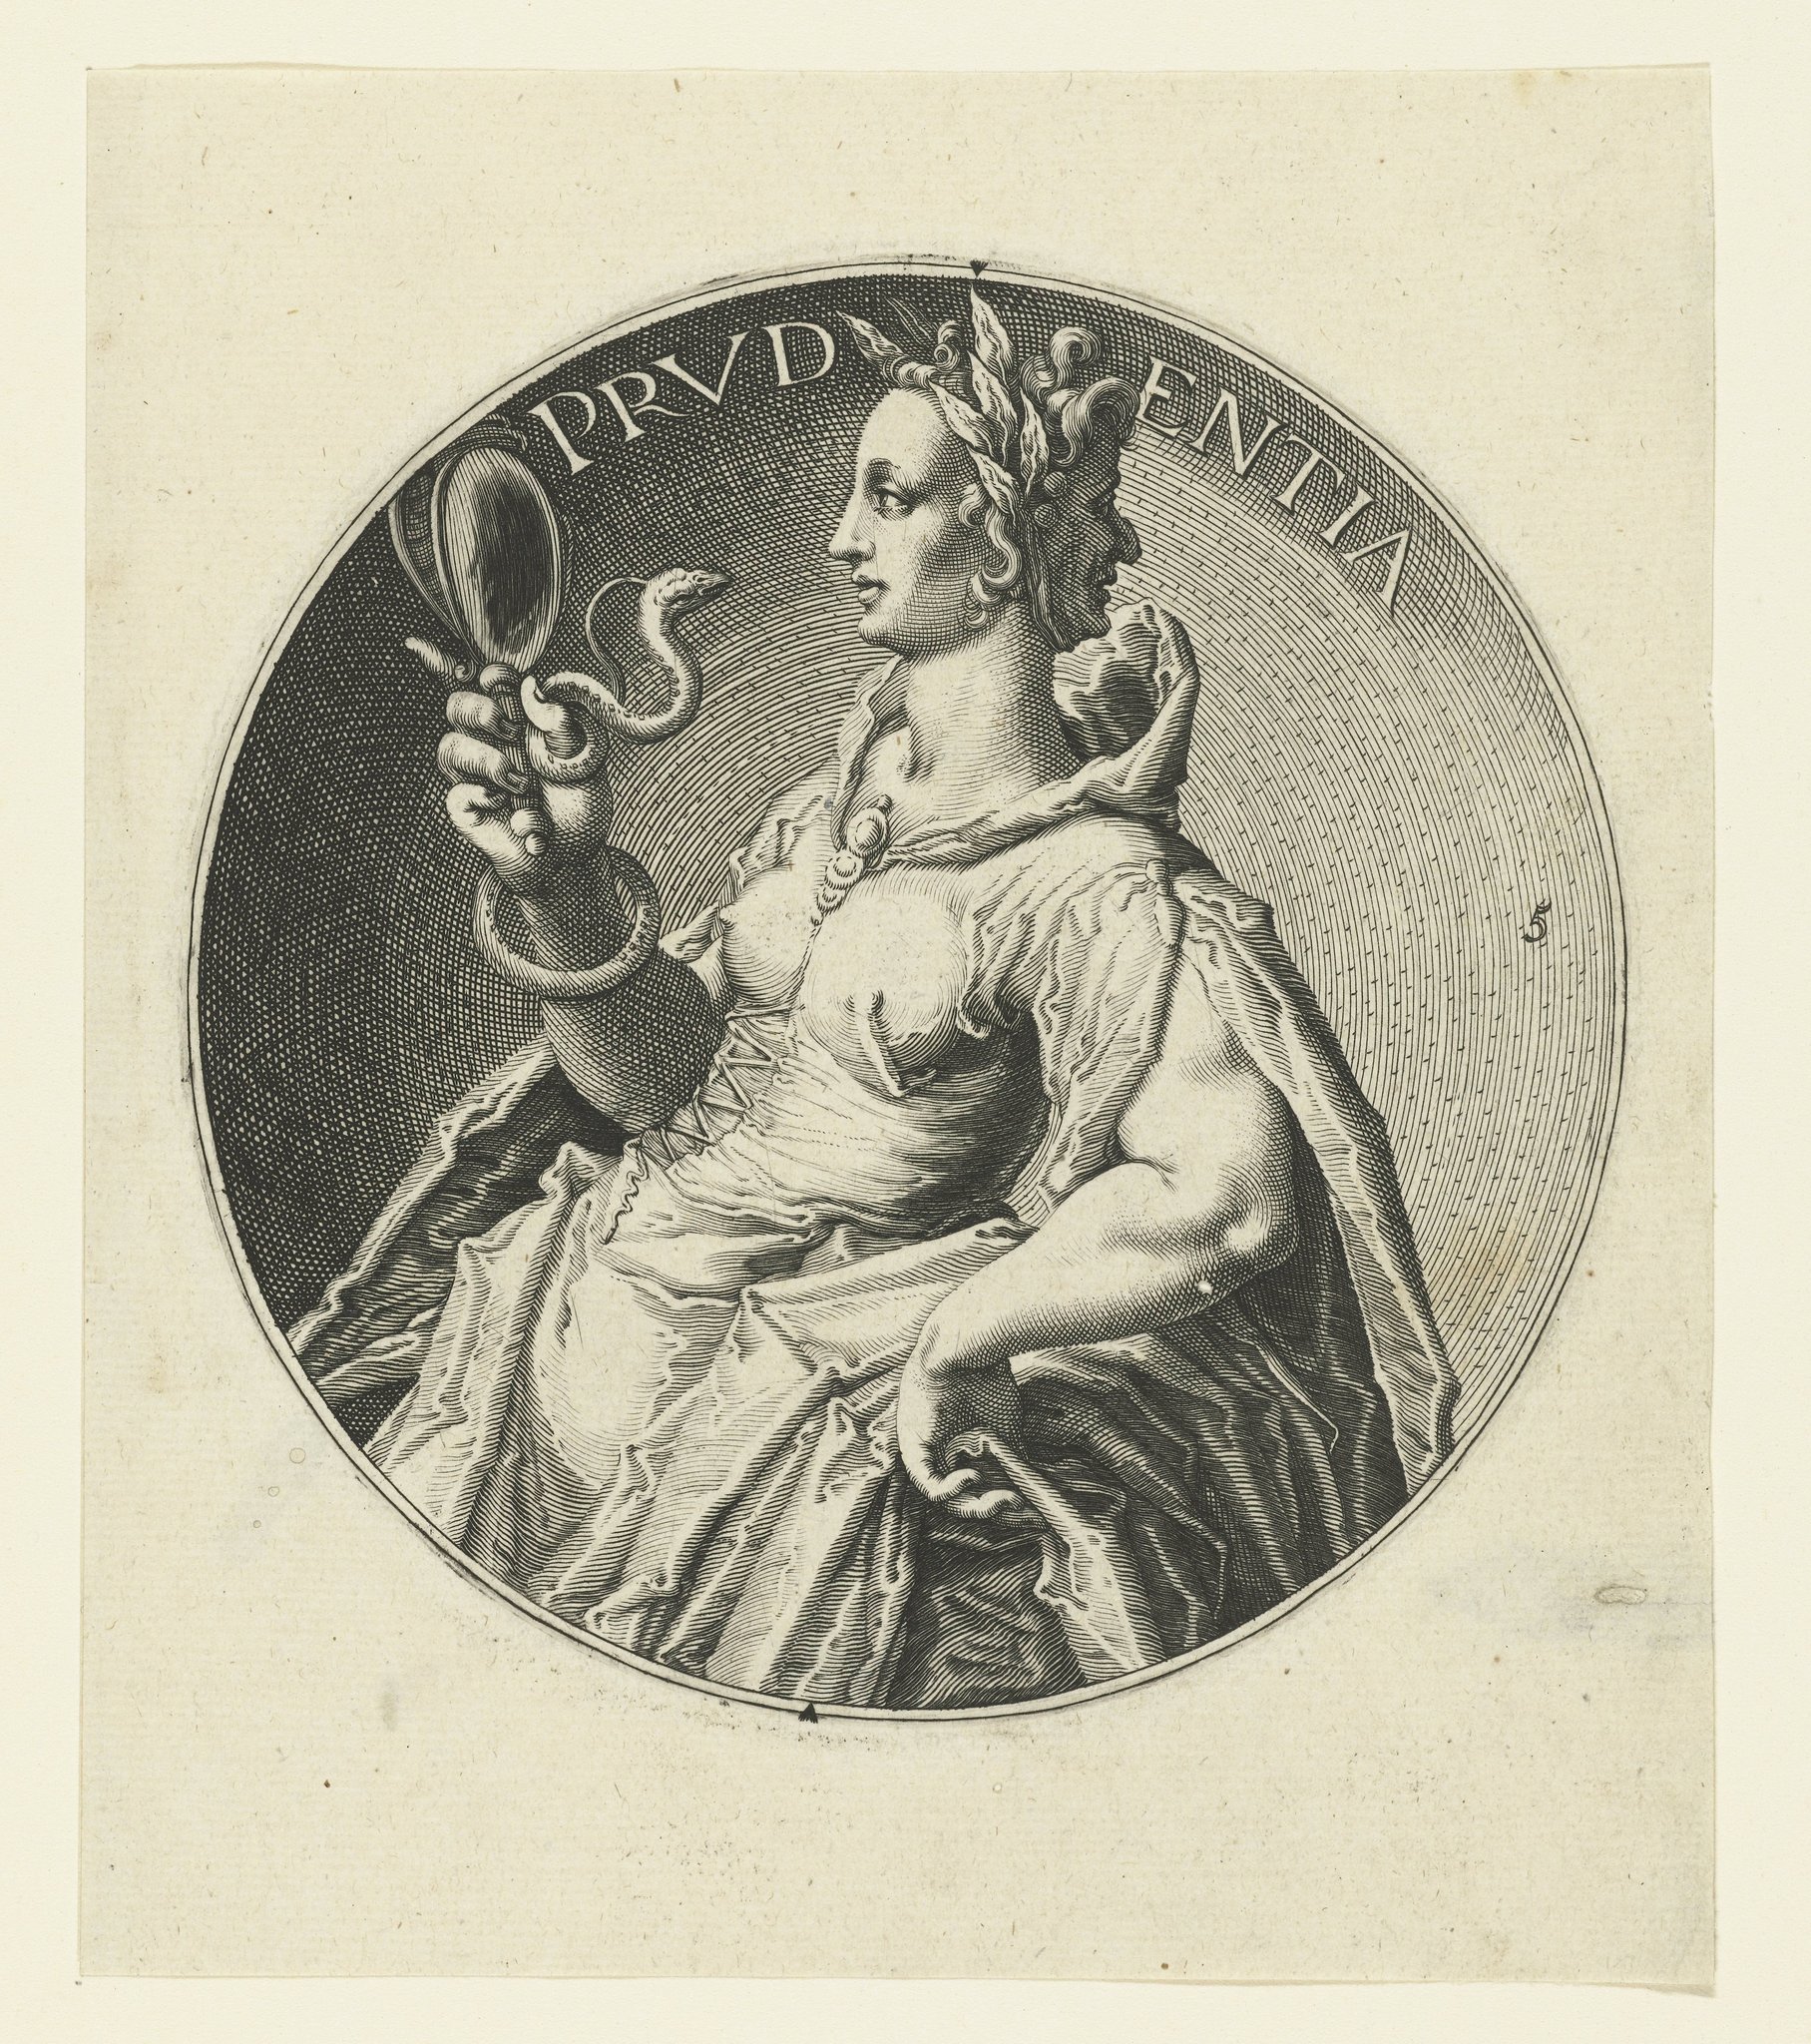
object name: print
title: Prudentia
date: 1591-1595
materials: paper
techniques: engraving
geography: netherlands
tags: prudence, 'prudentia'; 'prudenza' (ripa) ~ one of the four cardinal virtues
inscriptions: collector's mark: Lugt 2228a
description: Voorzichtigheid, in de gedaante van een vrouw met een spiegel in de rechterhand, waaromheen een slang kronkelt. Bovenin de voorstelling het woord 'PRVDENTIA' (voorzichtigheid). Deze prent is onderdeel van een serie van zeven ronde voorstellingen van de deugden, elk gepersonifieerd door een vrouwenfiguur met typerende attributen, en met Latijns opschrift.